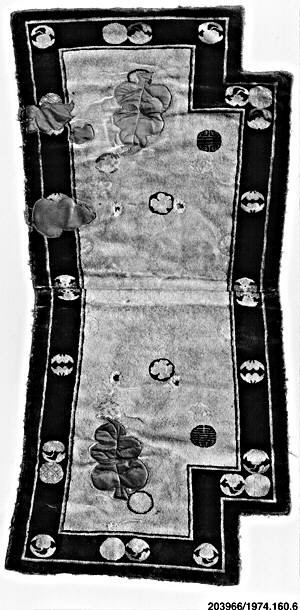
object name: rug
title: Saddle Rug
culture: chinese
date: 1701-1900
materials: cotton, wool